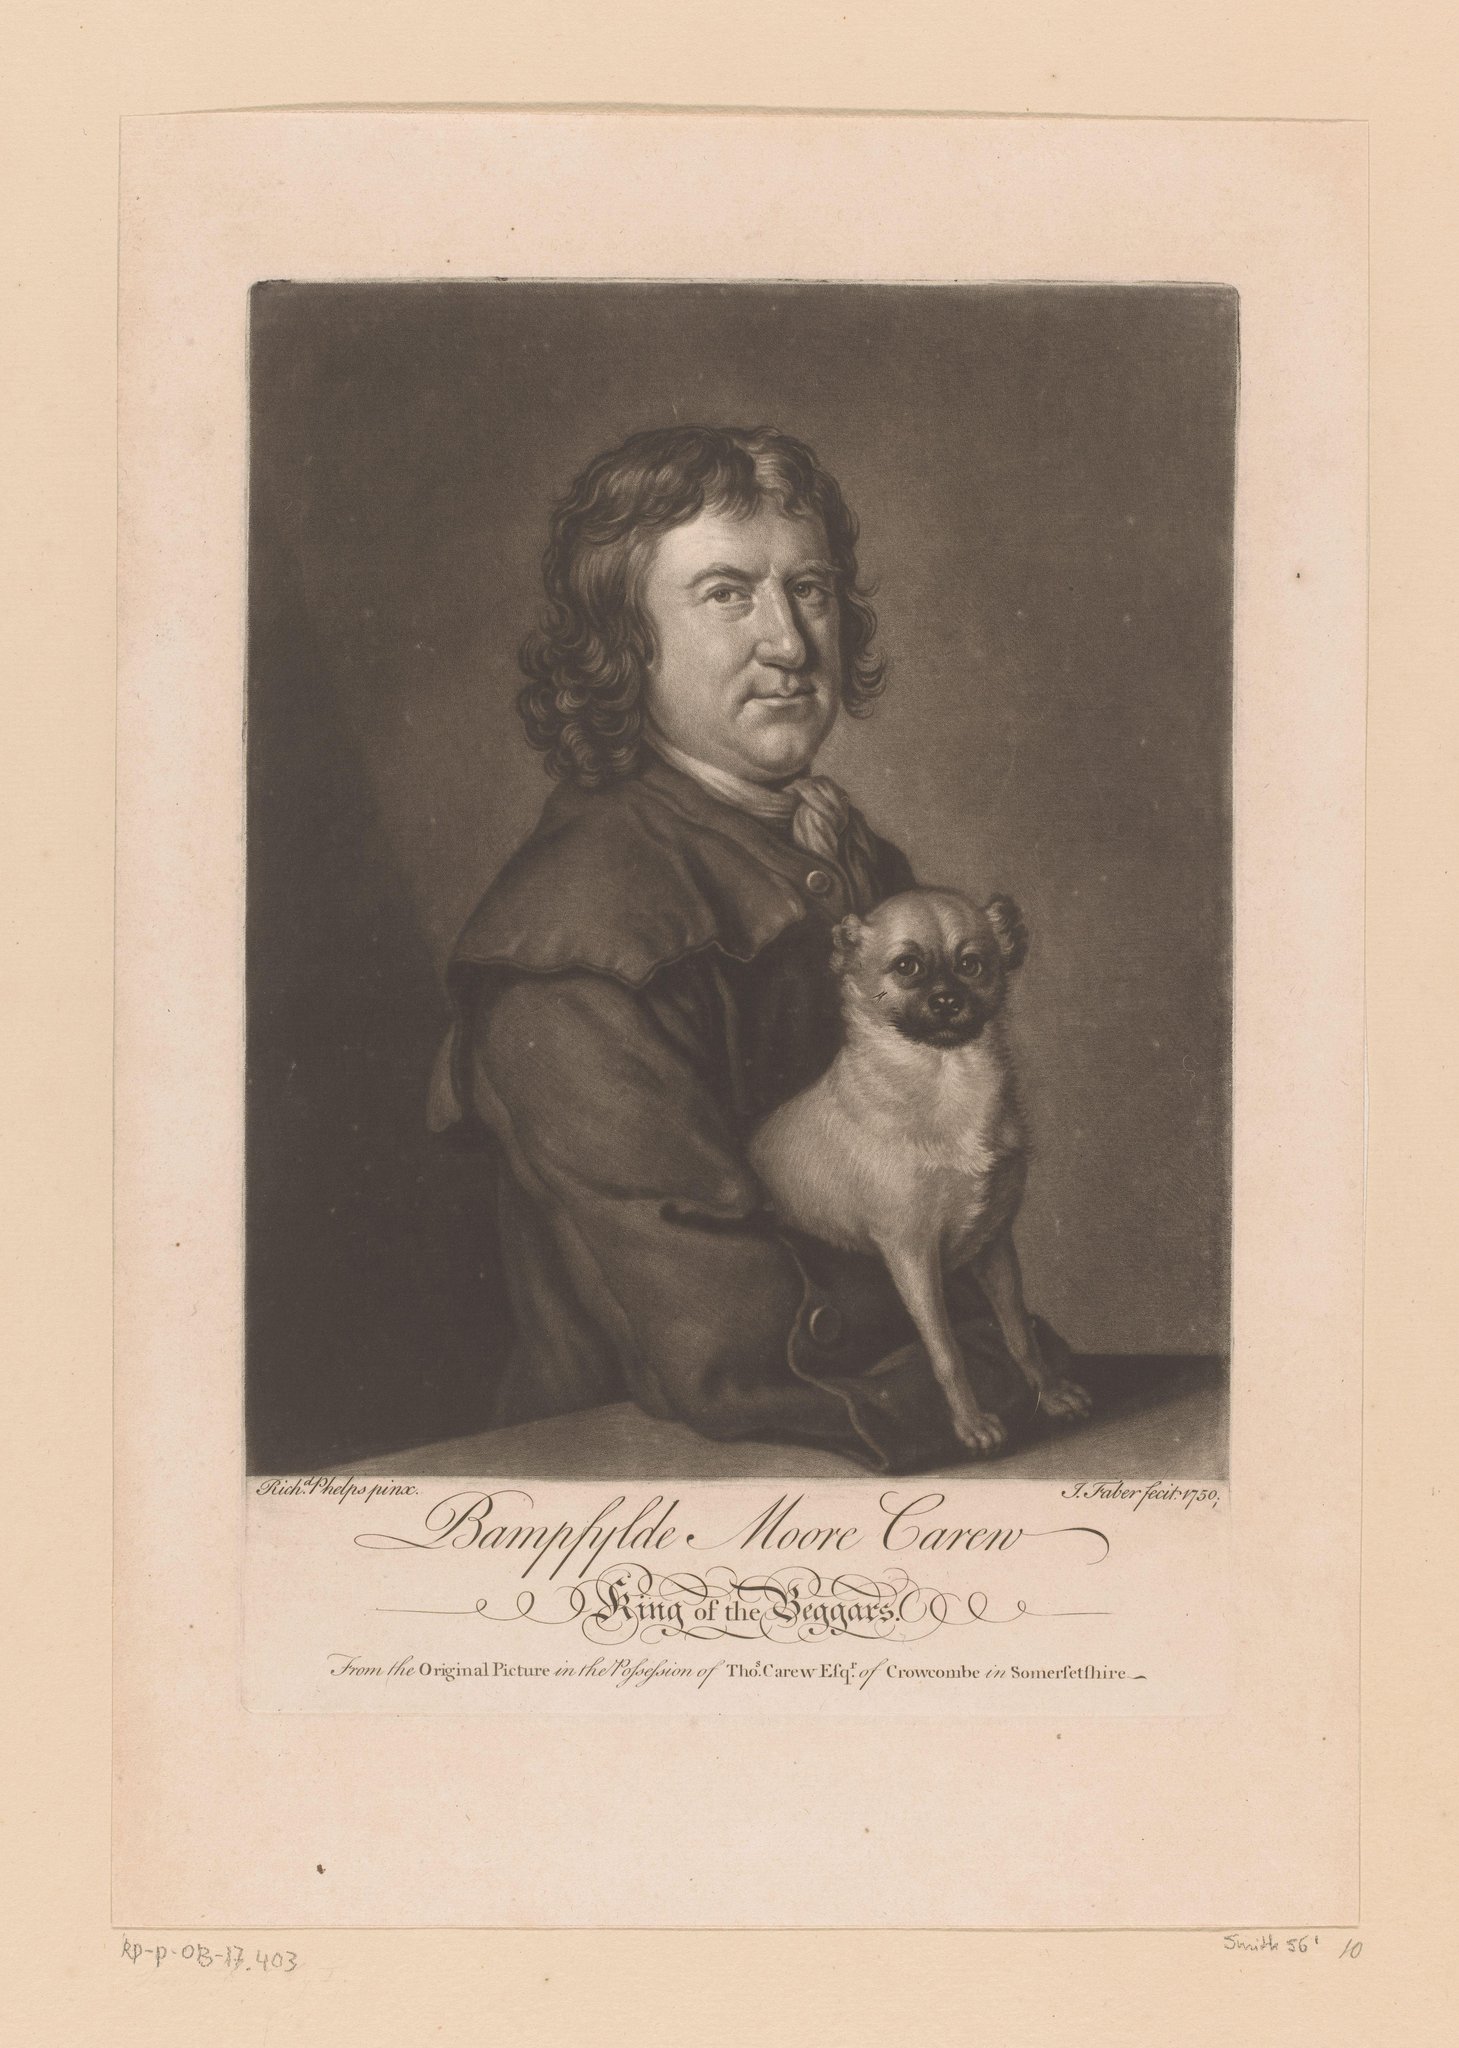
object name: print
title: Portret van Carew Bampfylde Moore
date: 1750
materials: paper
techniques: etching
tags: historical persons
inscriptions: collector's mark: Lugt 240